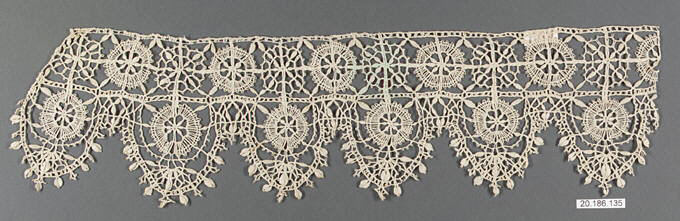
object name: edging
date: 1601-1700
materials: linen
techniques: lace